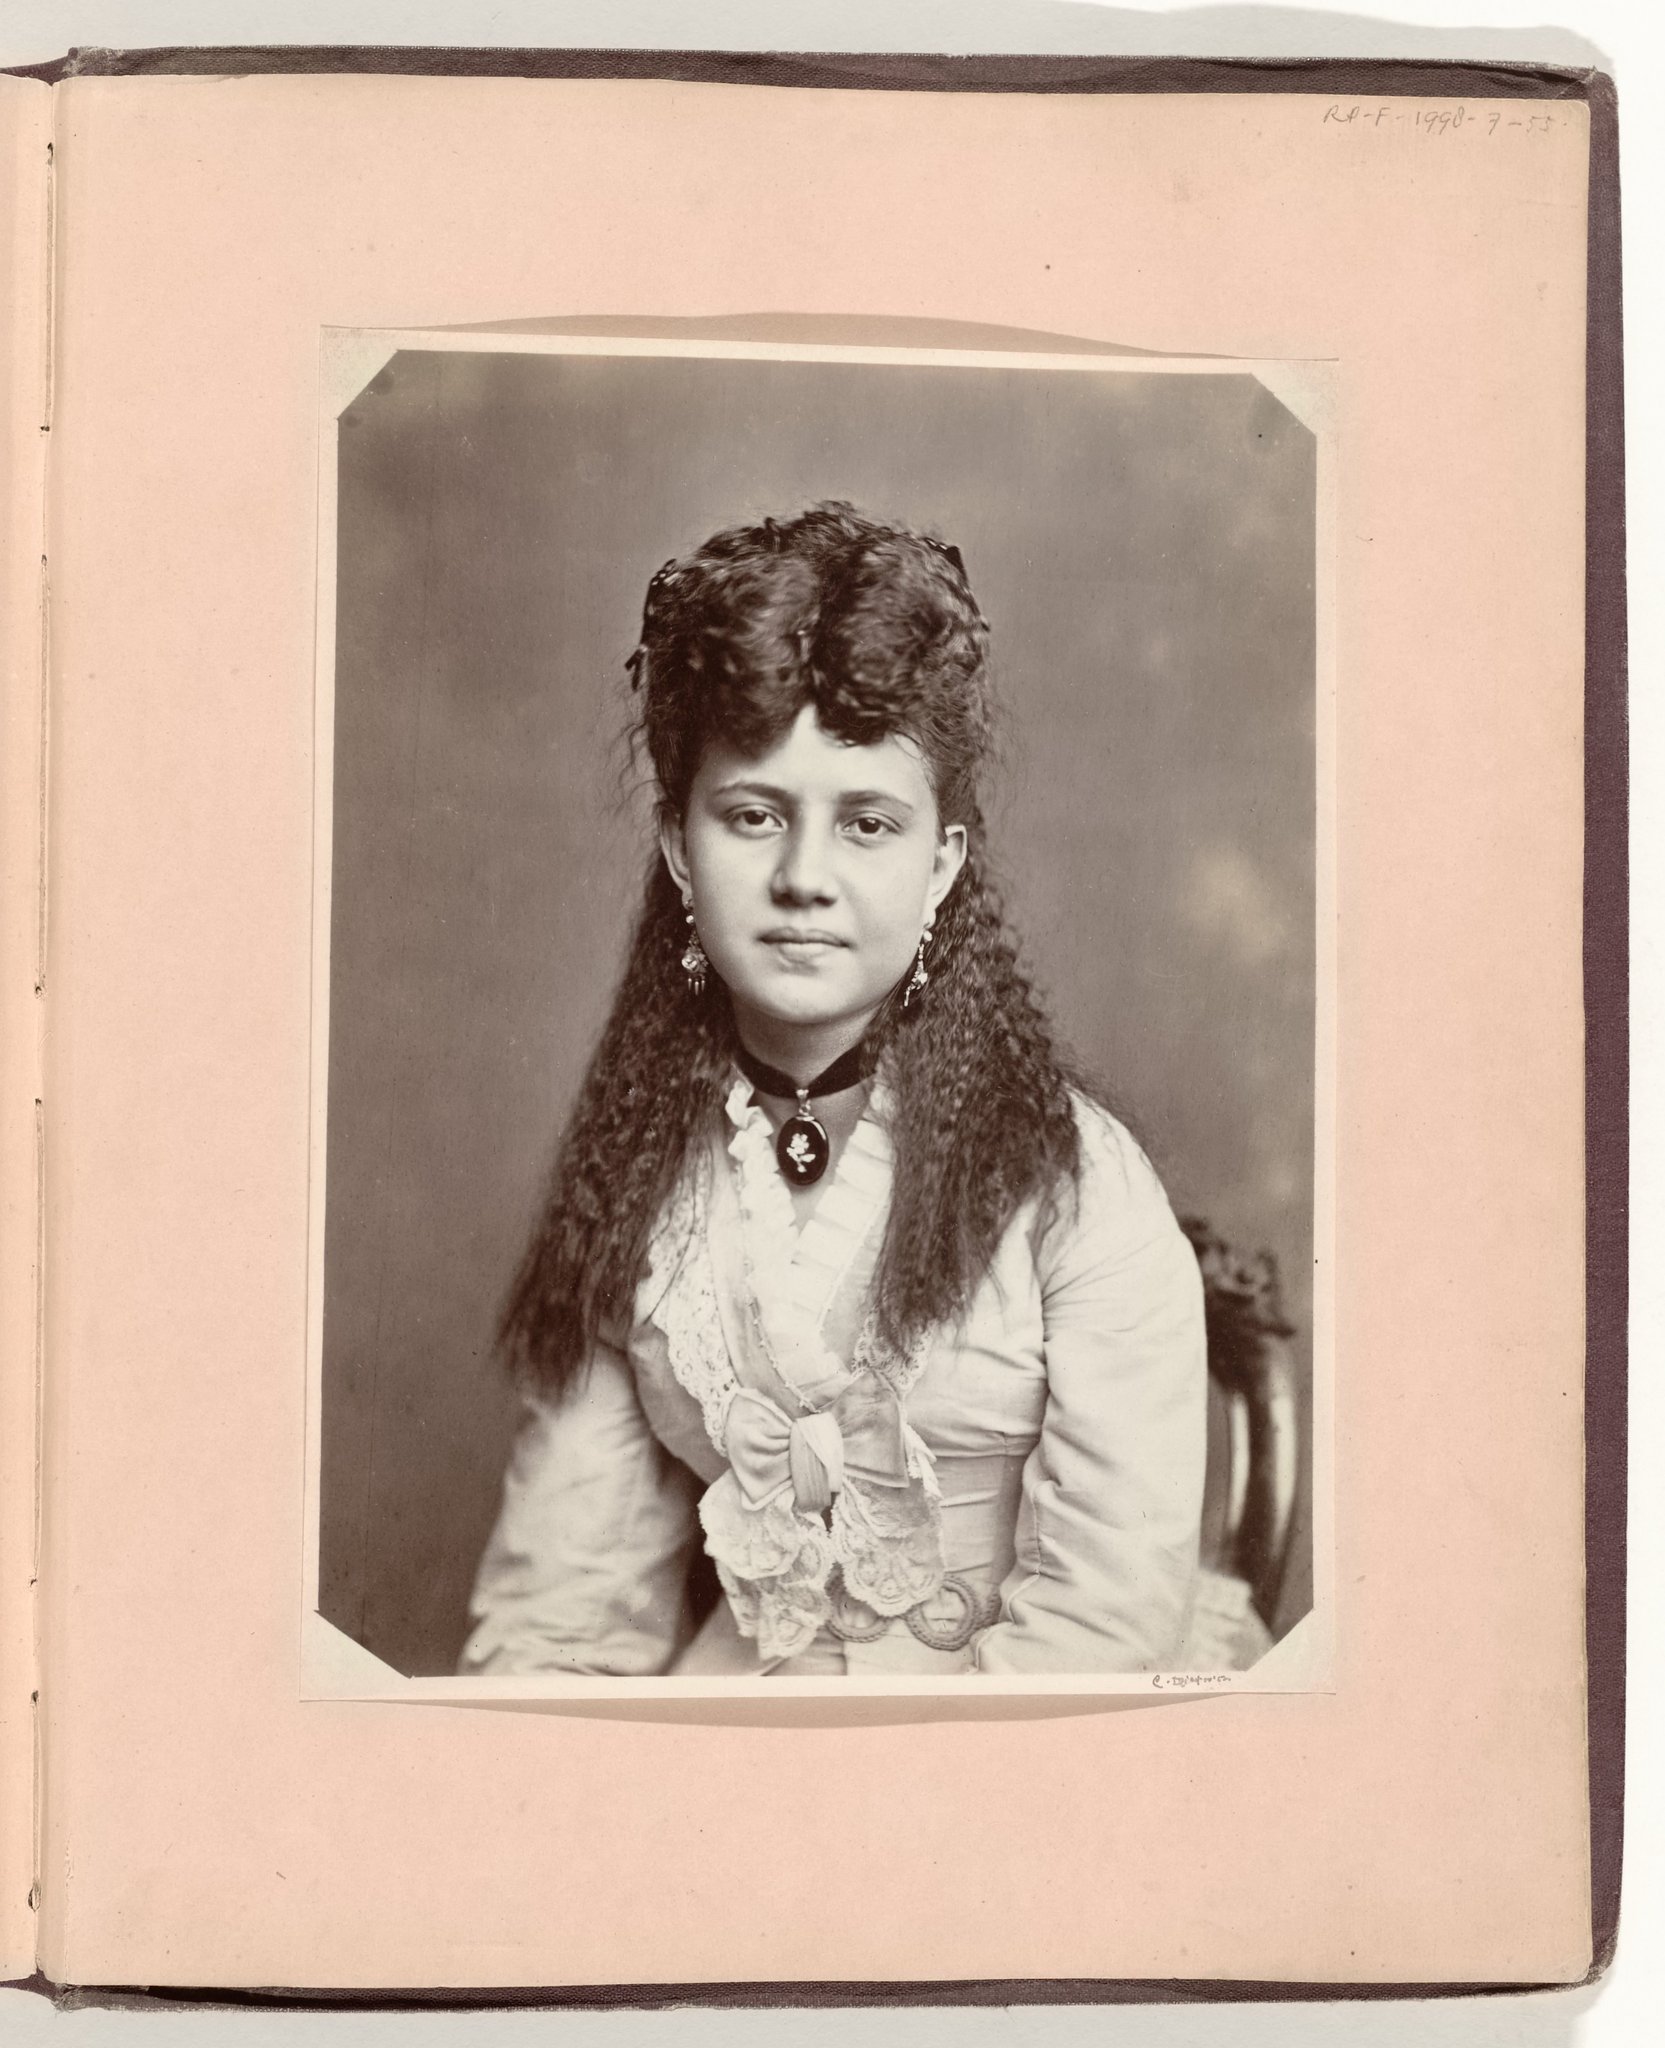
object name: photograph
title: Portret van een onbekende vrouw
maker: c. dietrich (fotograaf)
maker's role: fotograaf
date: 1875-1890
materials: cardboard, paper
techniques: albumen print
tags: anonymous historical person portrayed alone - bb - woman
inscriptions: signature: ‘C. Dietrich’